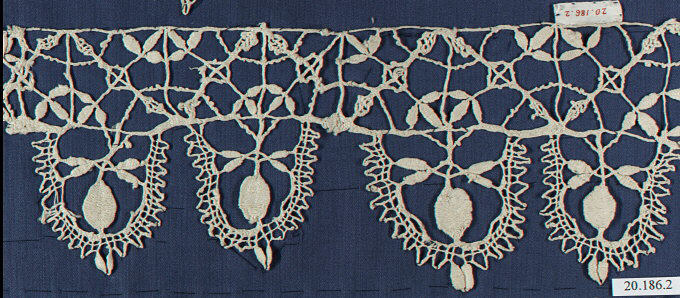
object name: edging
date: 1501-1700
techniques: lace